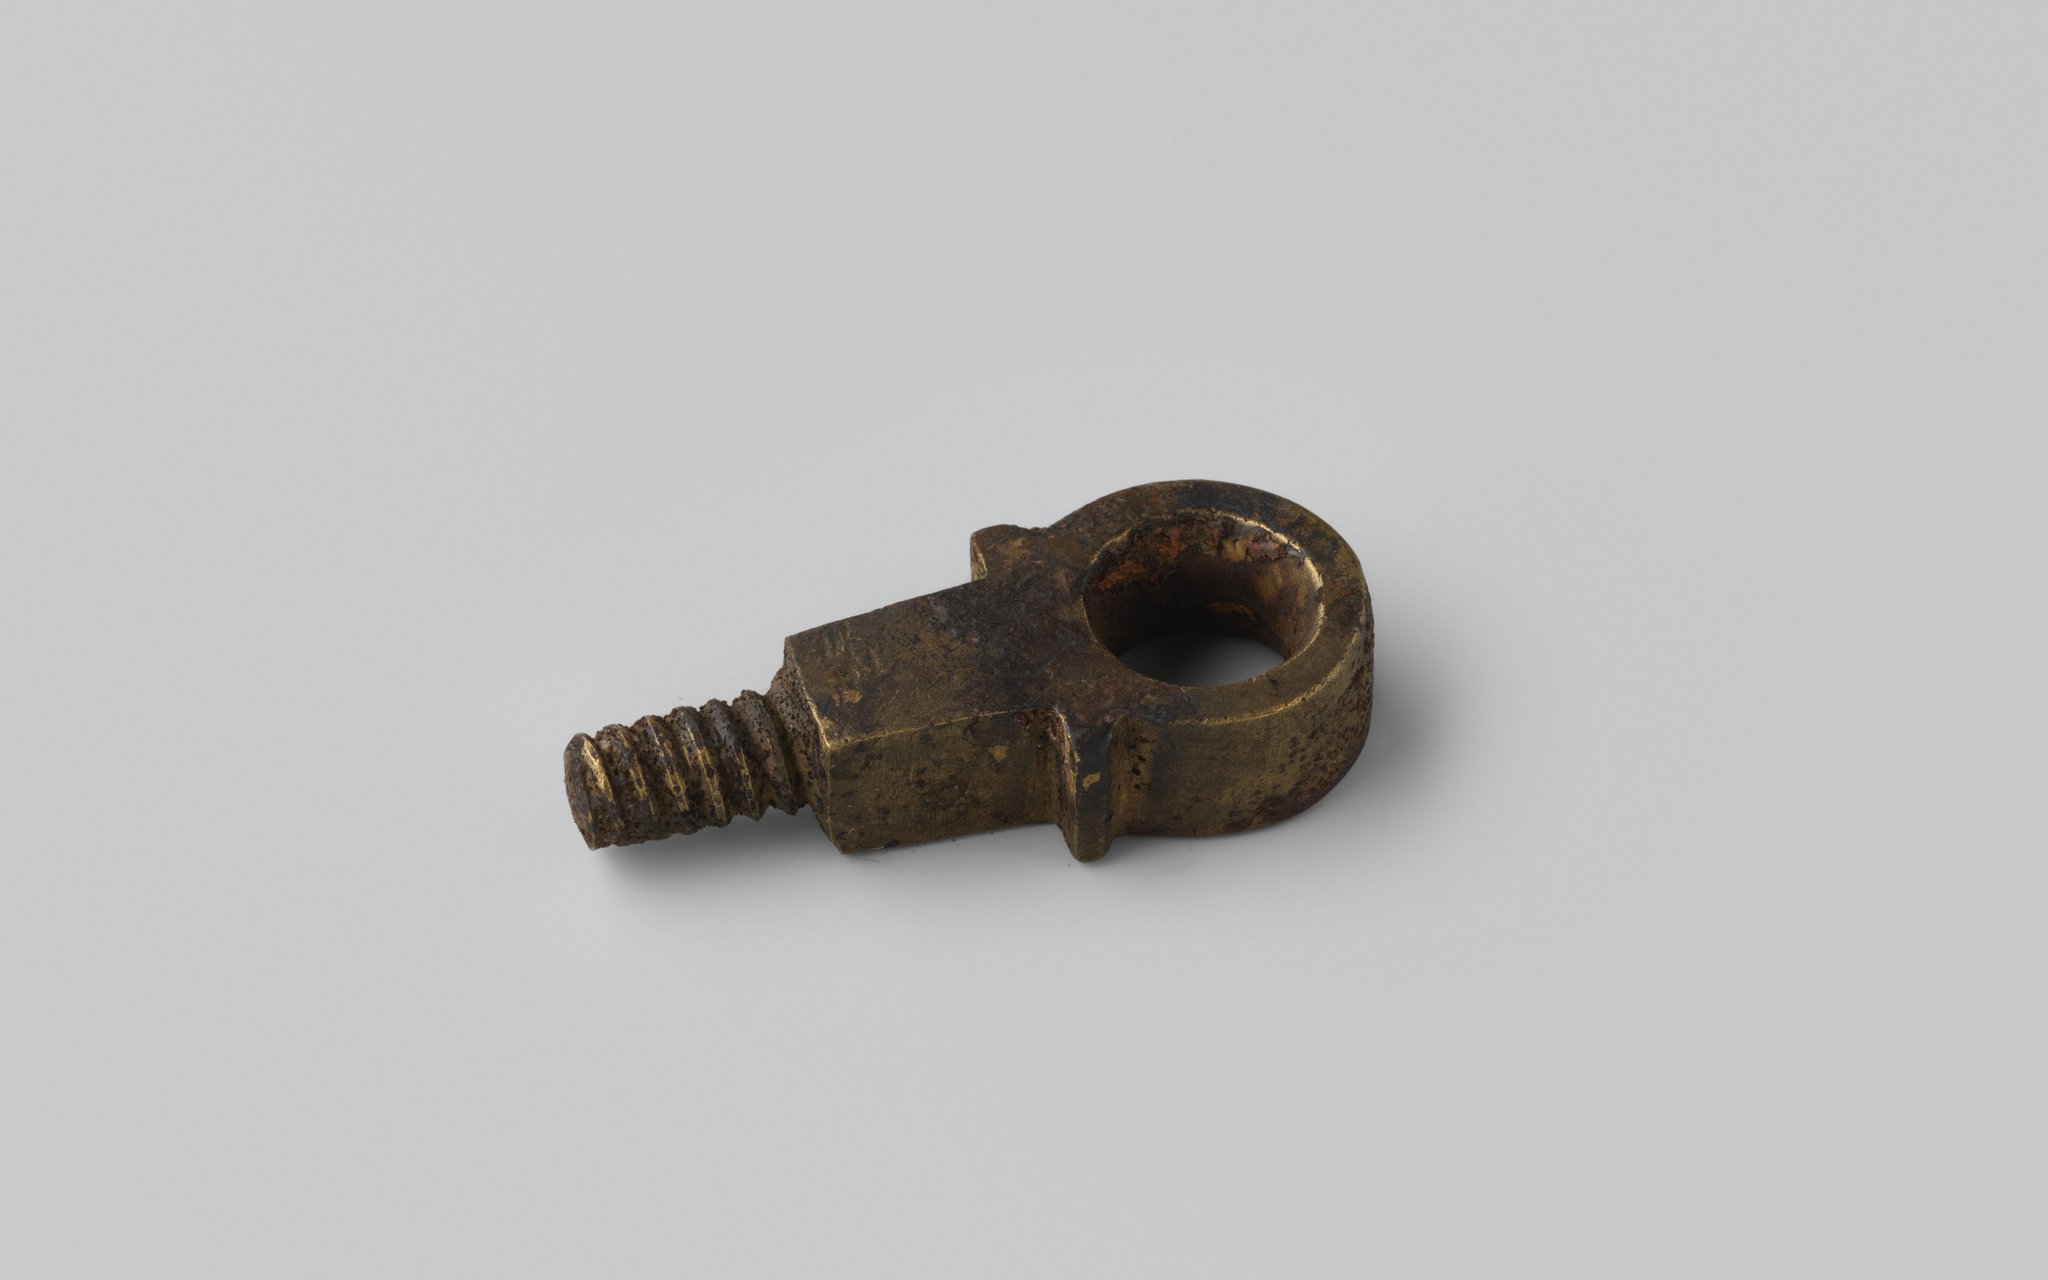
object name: screw eye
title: Schroefoog afkomstig uit het wrak van de Oost-Indiëvaarder Hollandia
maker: Anonymous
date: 1700-1743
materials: copper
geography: netherlands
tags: verenigde oostindische compagnie, hollandia (schip)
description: Screw eyes; flat tapering shaft, flanged circular pierced top, threaded shaft on lower end.